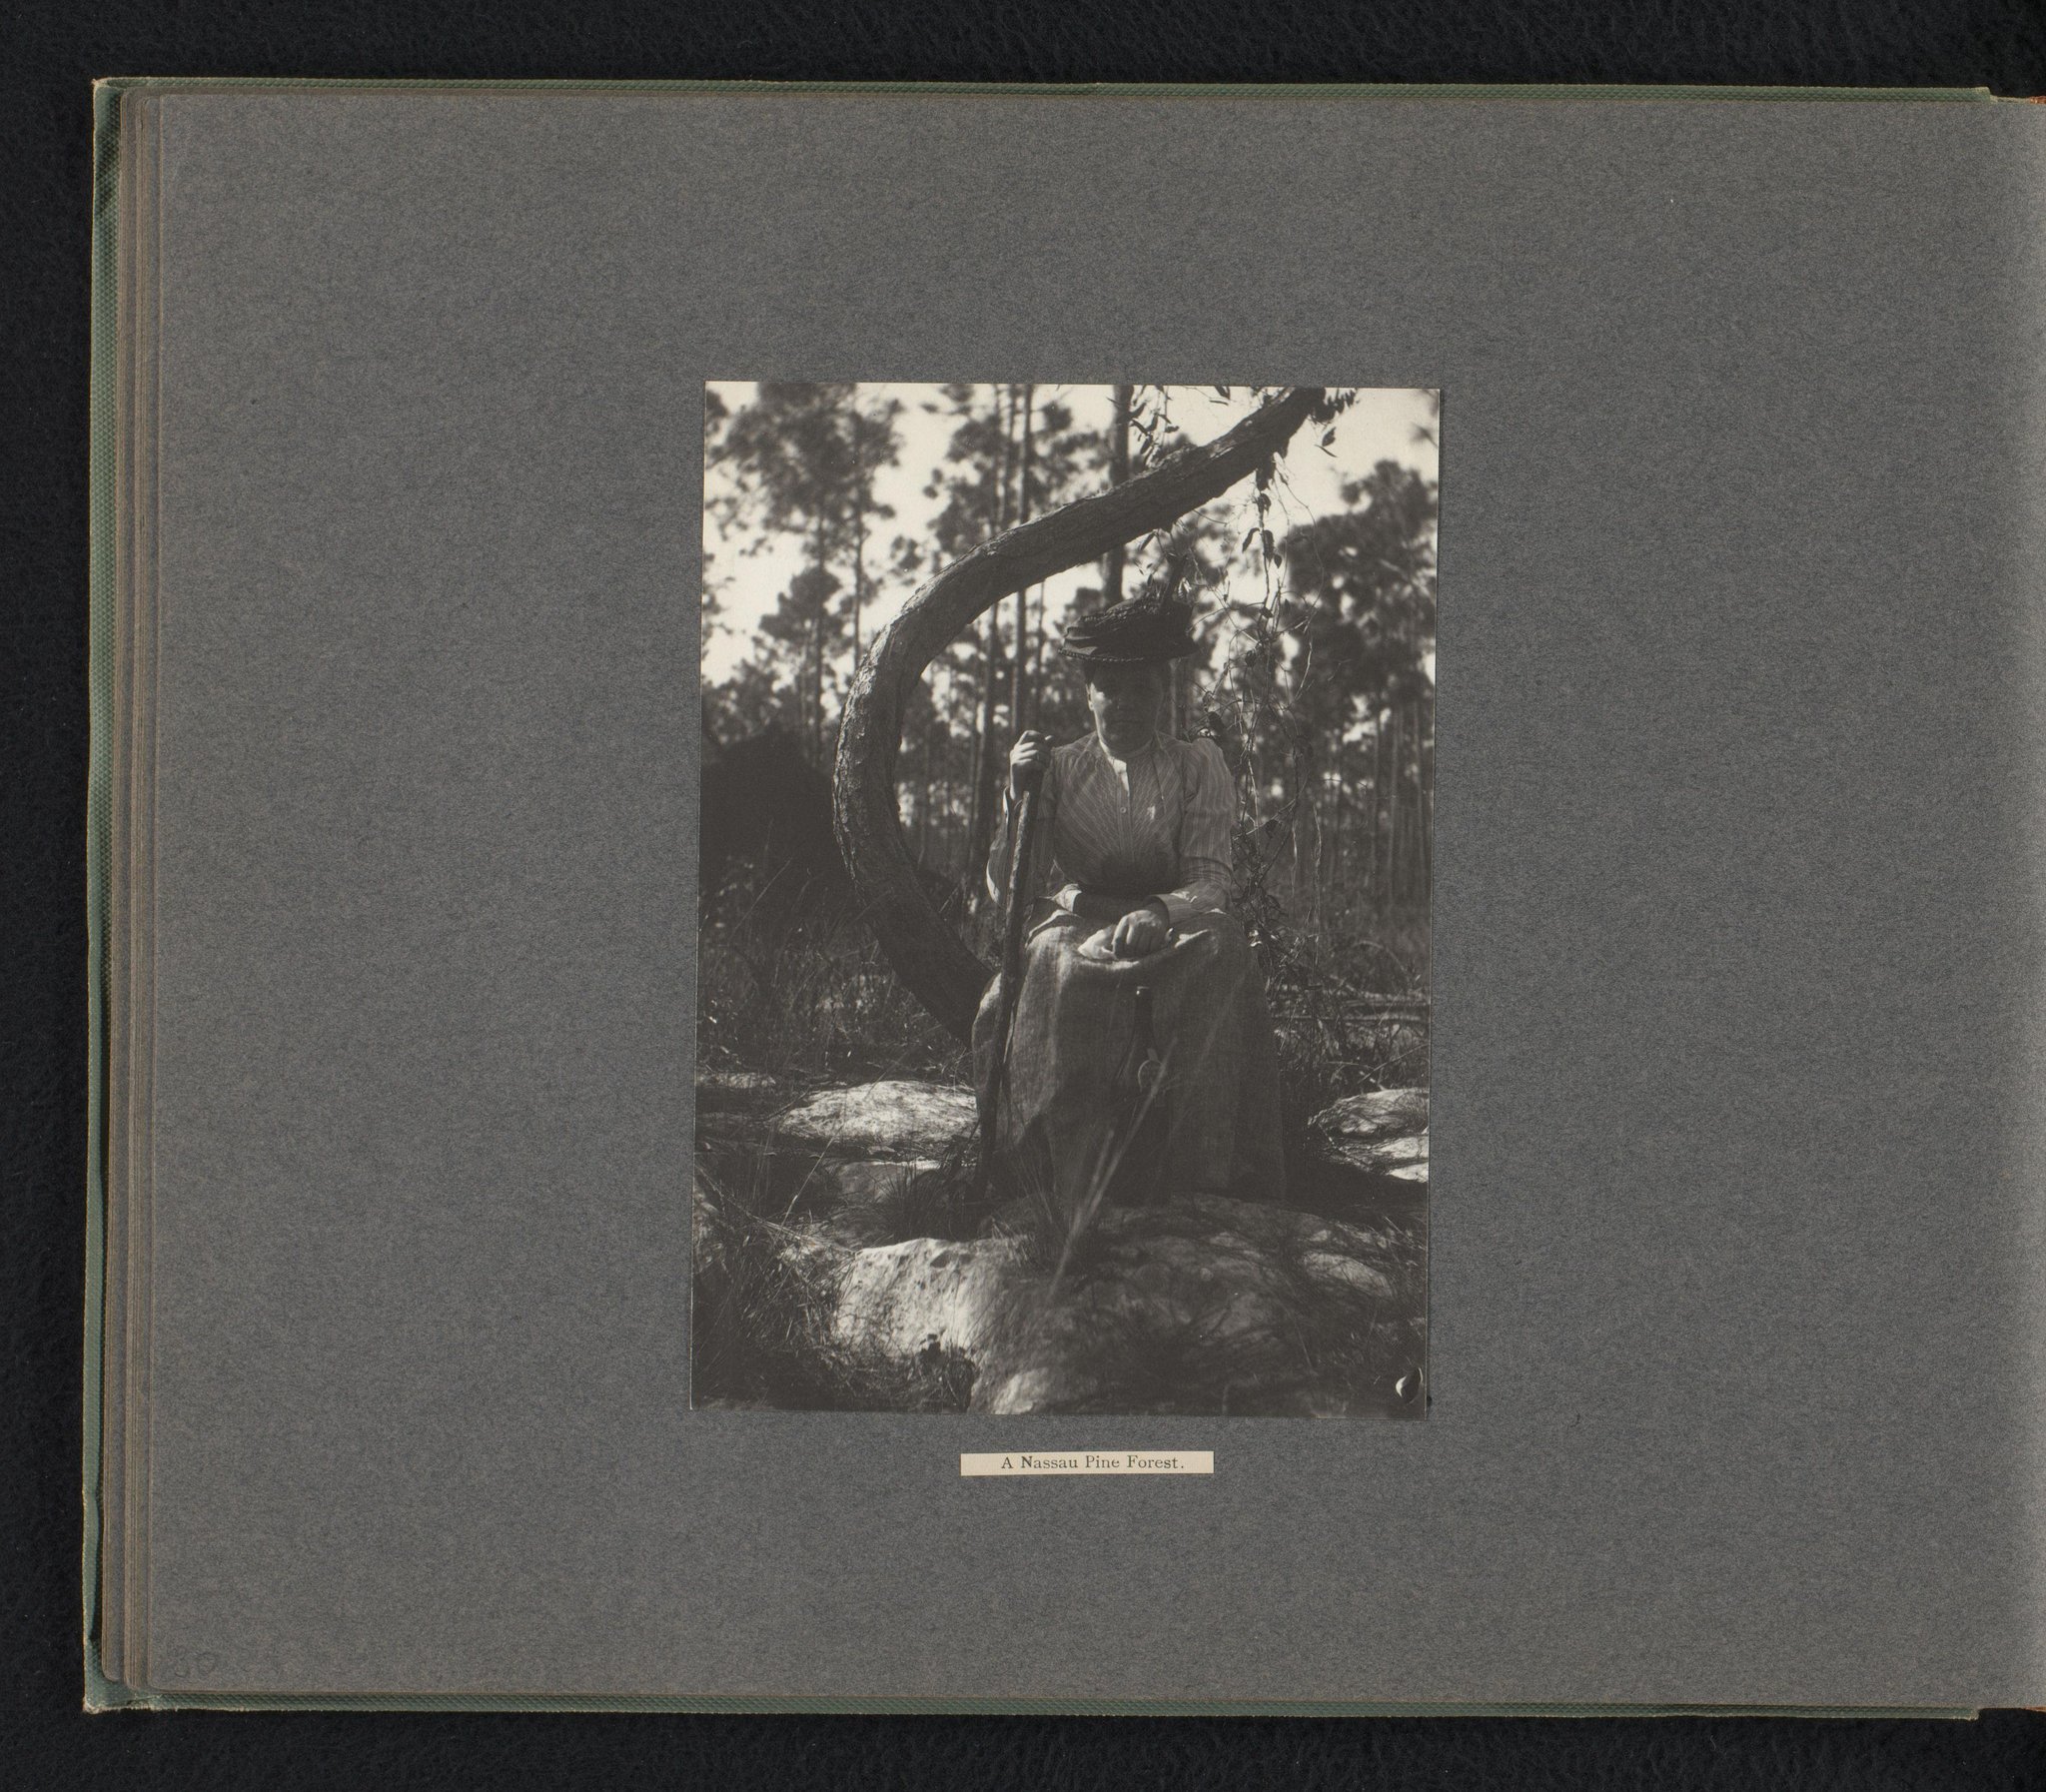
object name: photograph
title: Portret van een vrouw hurkend in een dennenbos op de Bahama's, een fles wijn op een steen voor haar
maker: Anonymous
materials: paper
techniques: platinum process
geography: bahamas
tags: historical persons - bb - woman, trees: pine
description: De gefotografeerde vrouw is mogelijk Jennie Bennett House, met wie Joseph Harvey Ladew in 1901 trouwde.